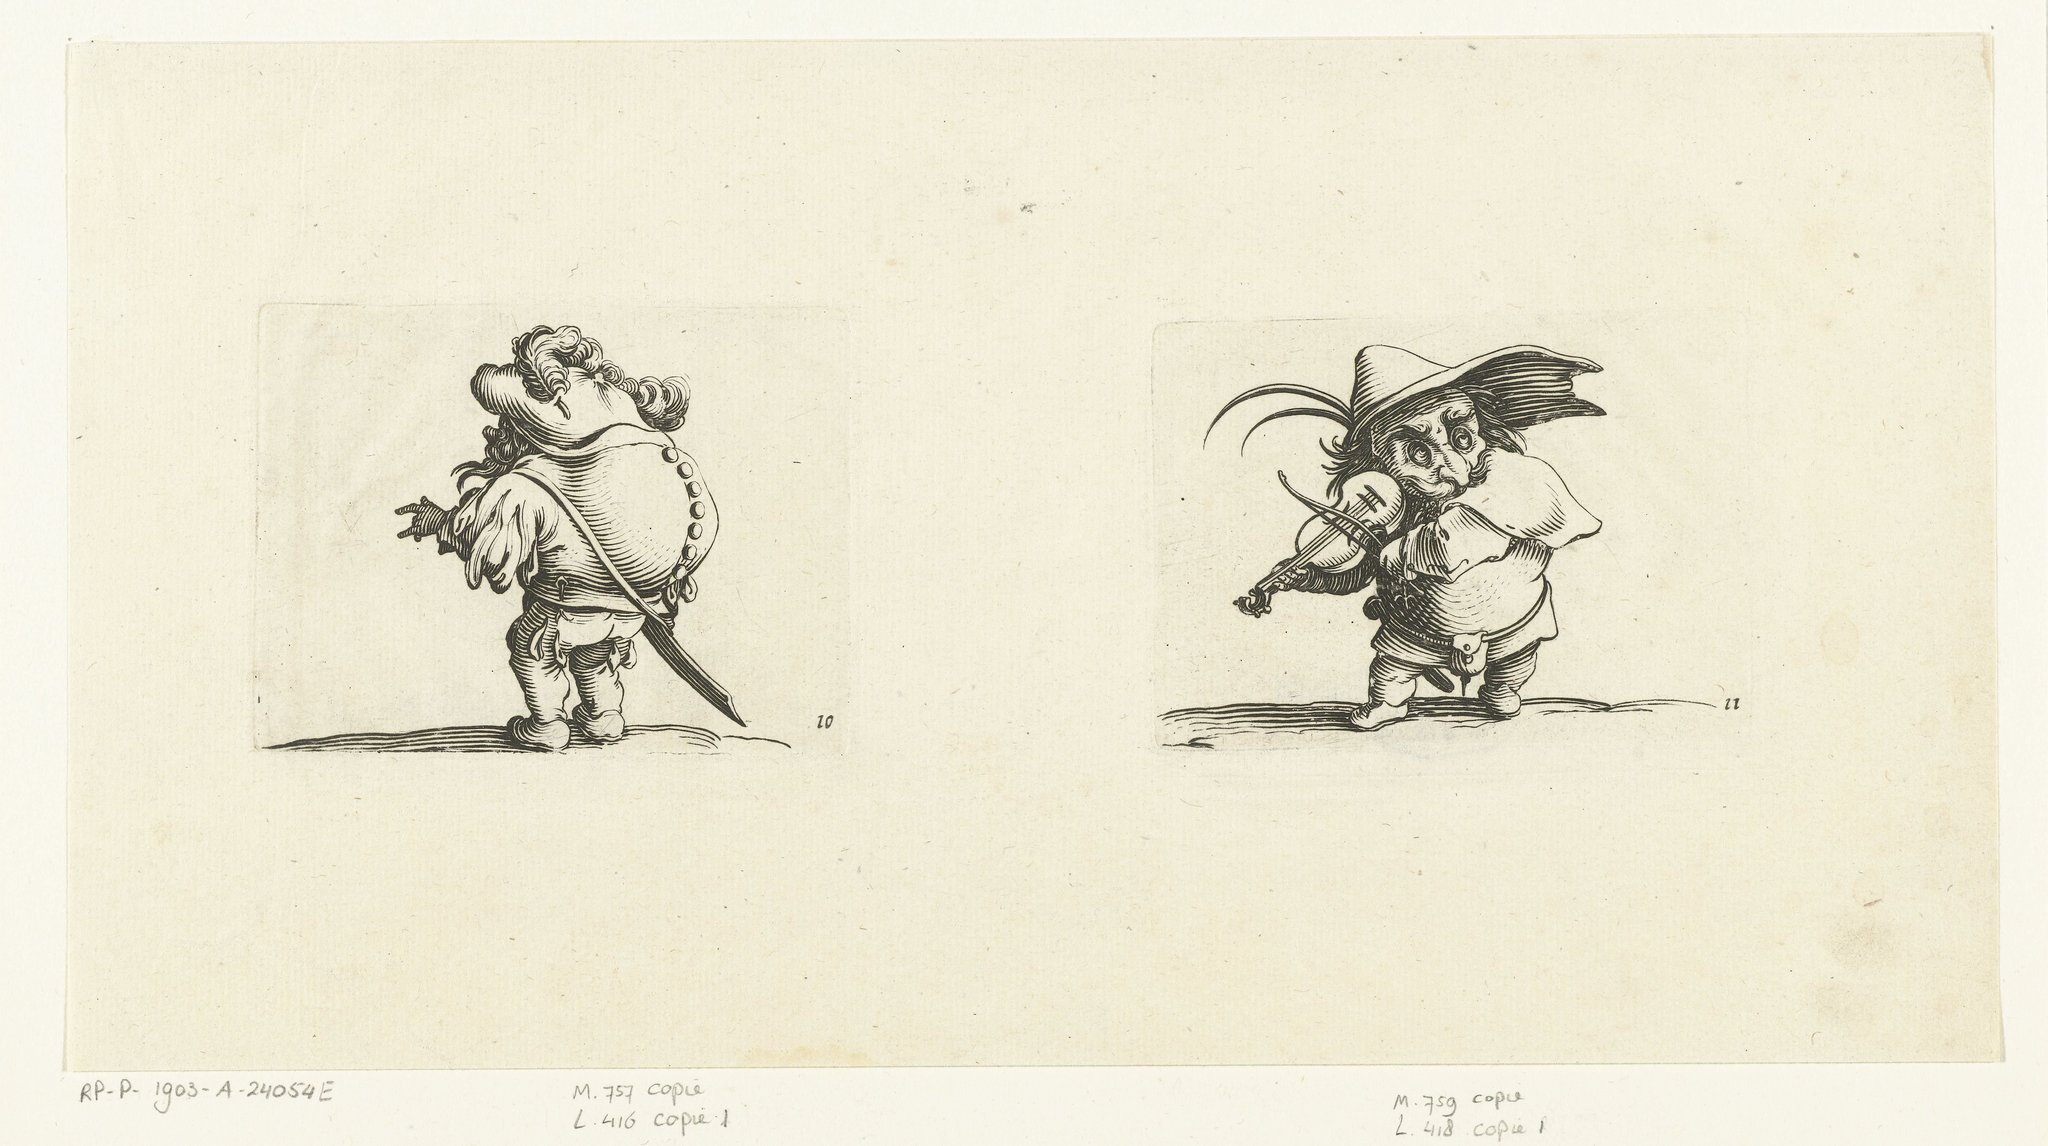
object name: print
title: Diverse groteske figuren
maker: abraham bosse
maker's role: draughtsman, print maker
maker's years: 1602-1676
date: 1621-1676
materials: paper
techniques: engraving, etching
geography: paris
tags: one person playing string instrument (bowed), little people, violin, fiddle, hacking and thrusting weapons: sword, hunchback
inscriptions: collector's mark: Lugt 2228a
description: Links: kleine mens (karikatuur), min of meer op de linkerzijde gezien, met een gebochelde rug waarover een knopenrij loopt, een muts met veren op het hoofd, een zwaard aan zijn rechterzijde. Rechts: kleine mens (karikatuur), van voren gezien, een viool bespelend, een hoed met twee veren op het hoofd, een zwaard aan zijn rechterzijde. Deze beide prenten, naast elkaar op 1 blad gedrukt, zijn onderdeel van een serie van 21 prenten (op 11 bladen gedrukt, dus m.u.v. de titelprent steeds 2 platen per blad) met groteske figuren; vrijwel al die figuren zijn karikaturen van kleine mensen, velen zijn gebocheld.